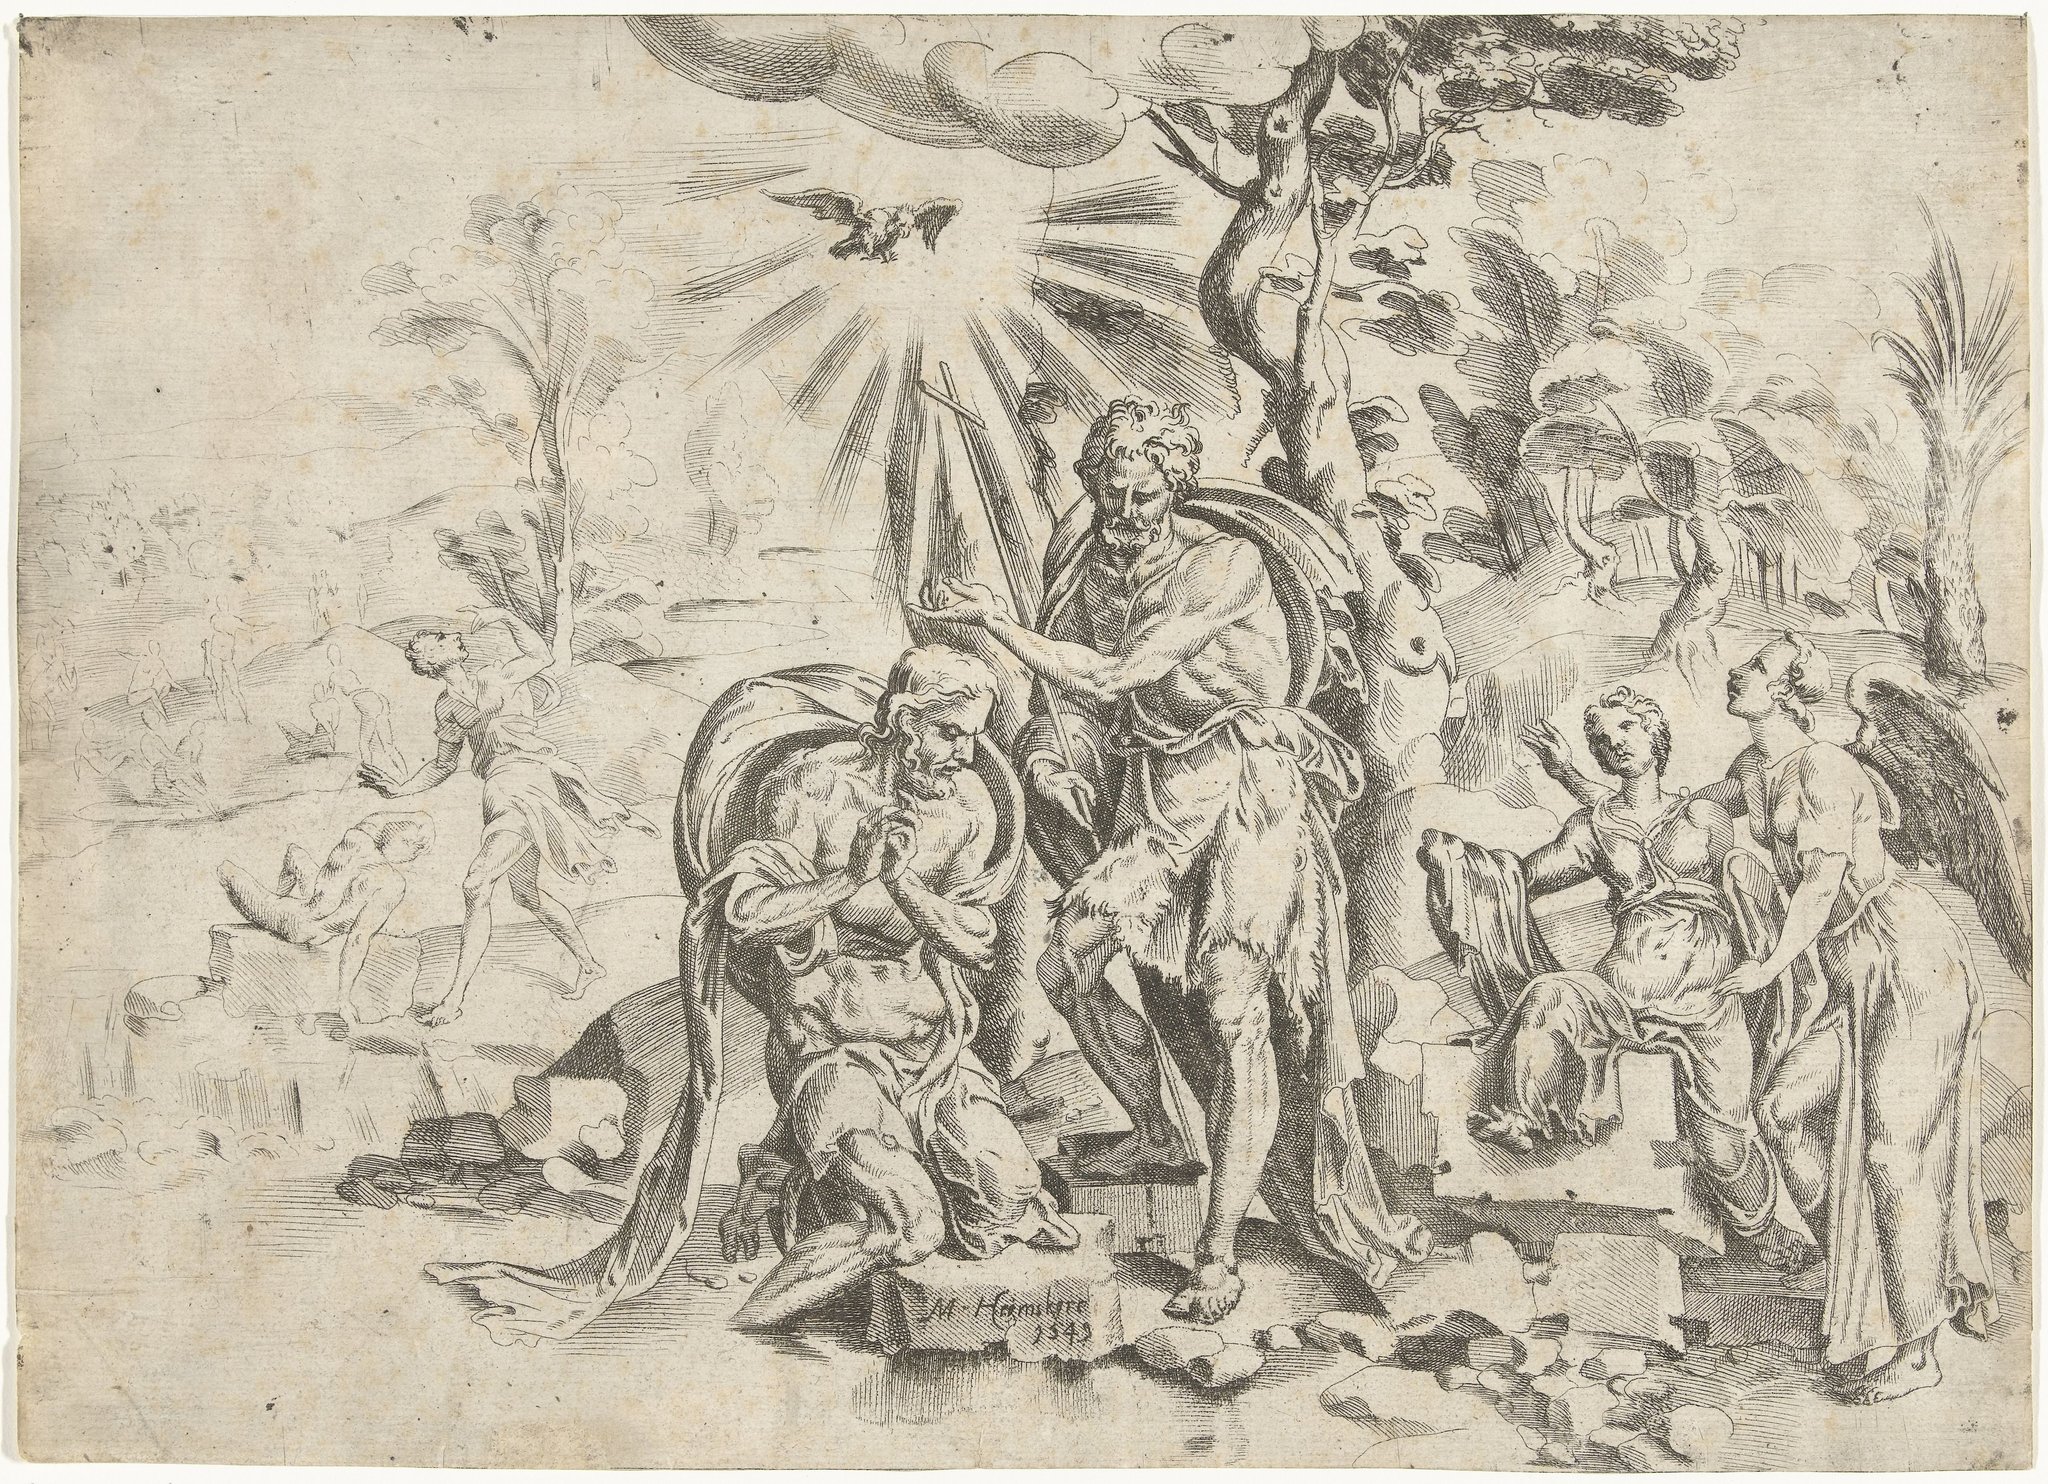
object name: print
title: Doop van Christus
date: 1549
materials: paper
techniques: etching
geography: haarlem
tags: baptism of christ in the river jordan: john the baptist pouring out water on christ's head: the holy ghost descends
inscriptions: collector's mark: Lugt 2228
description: Christus wordt door Johannes de Doper in de Jordaan gedoopt. Boven hun hoofden de duif van de Heilige Geest. Engelen houden Christus' kleren vast op de oever.